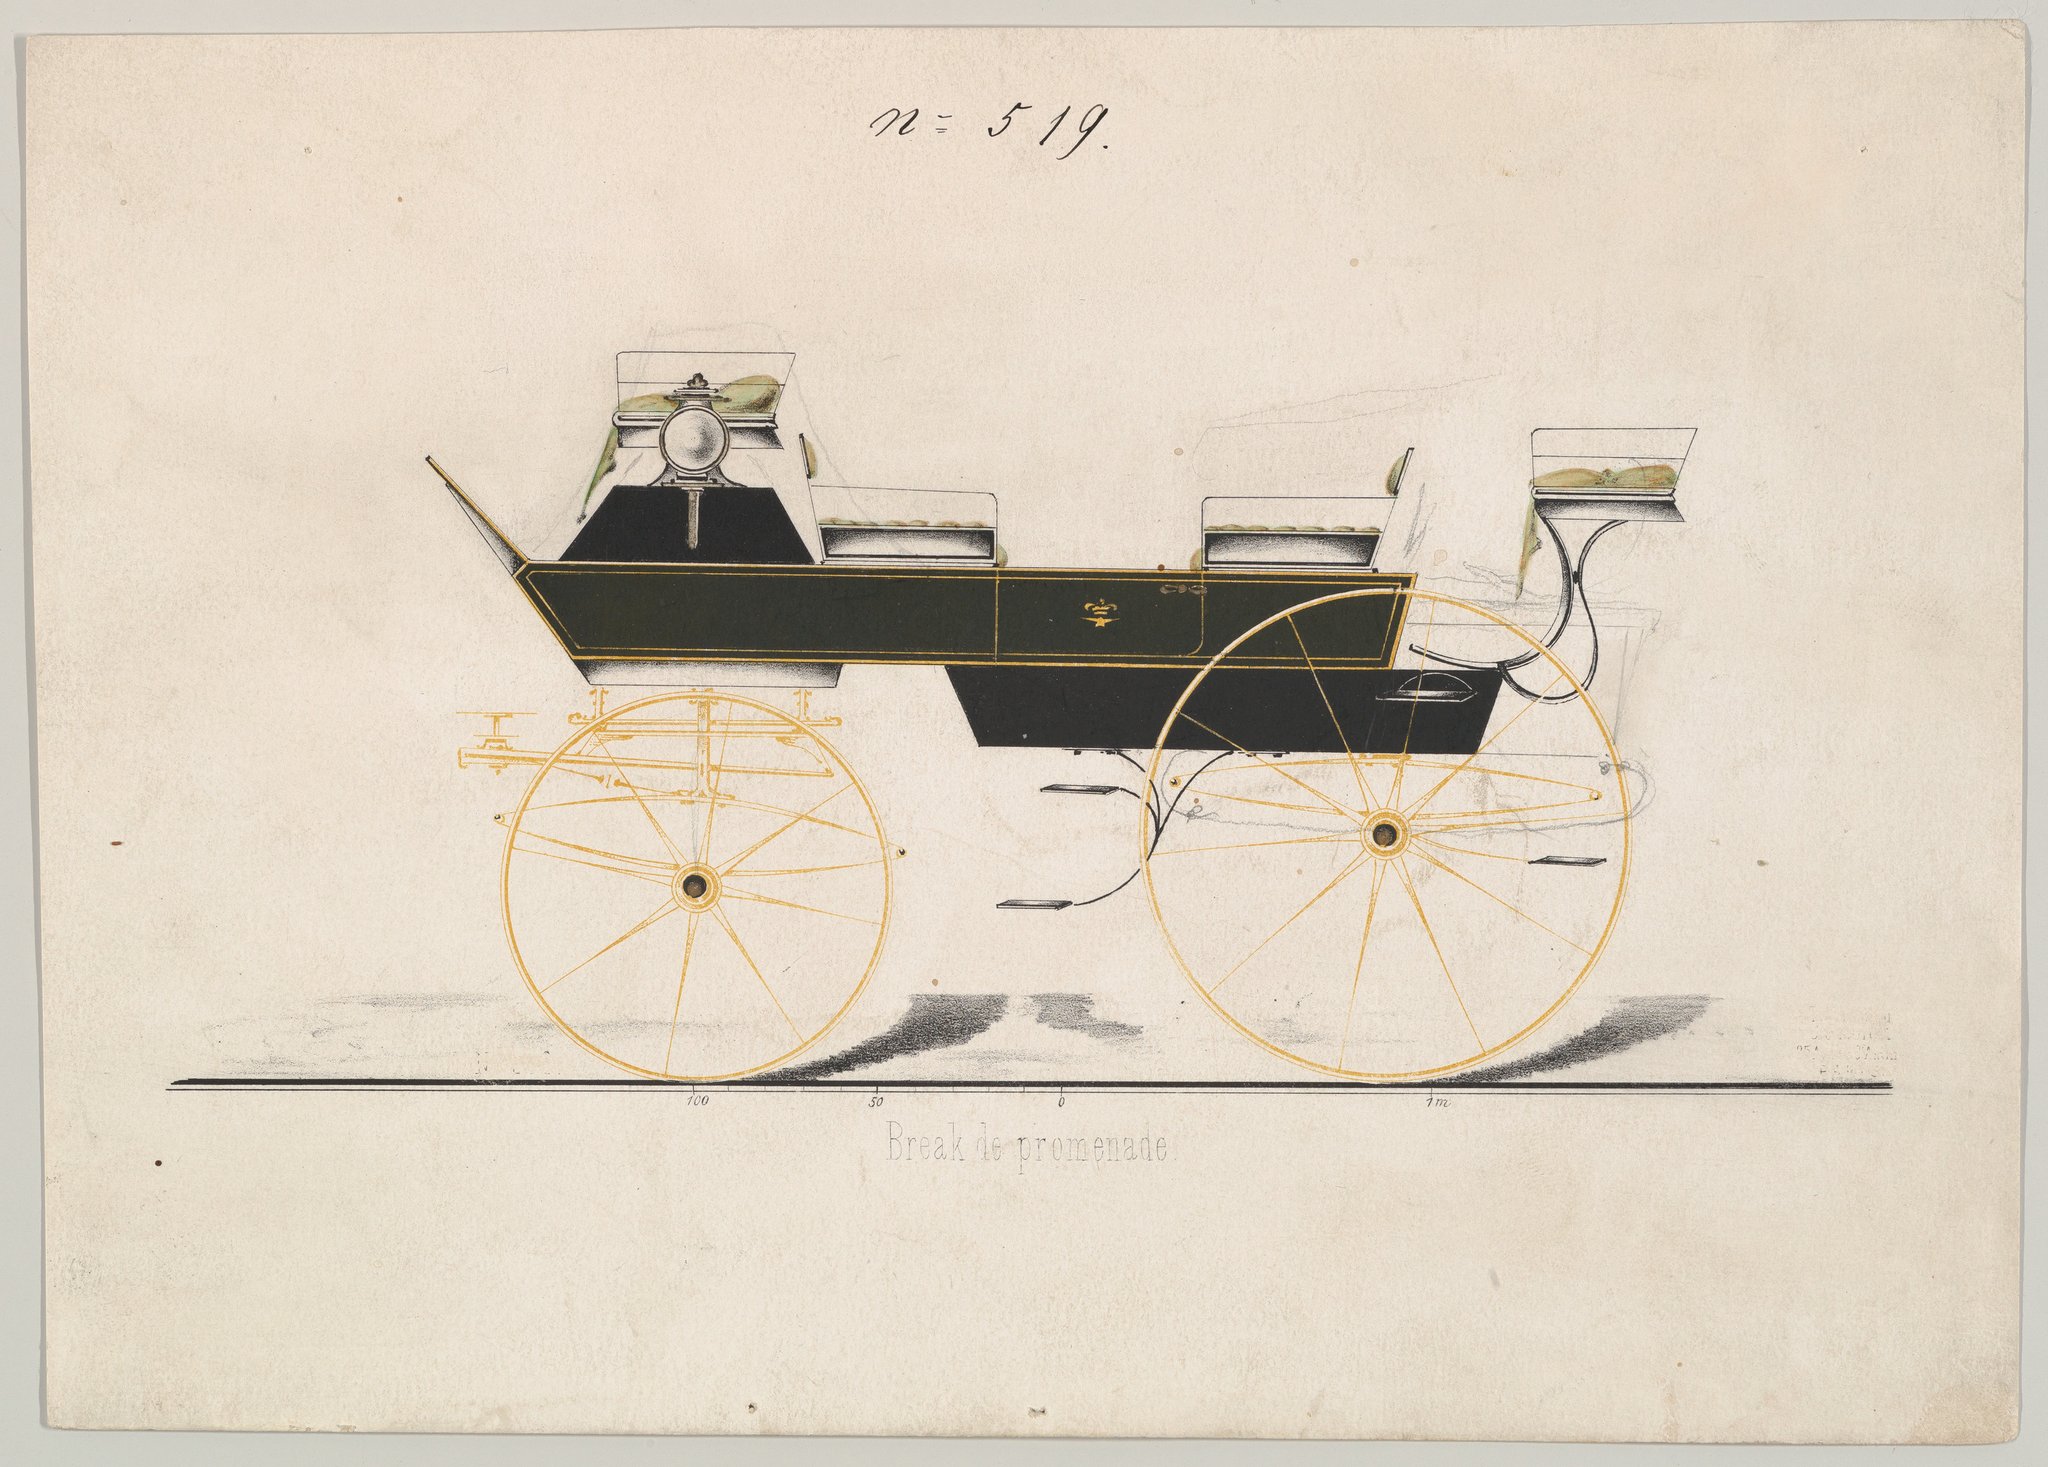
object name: print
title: Break de Promenade #519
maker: brewster & co.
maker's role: manufacturer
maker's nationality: american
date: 1850-1870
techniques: lithograph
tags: carriages